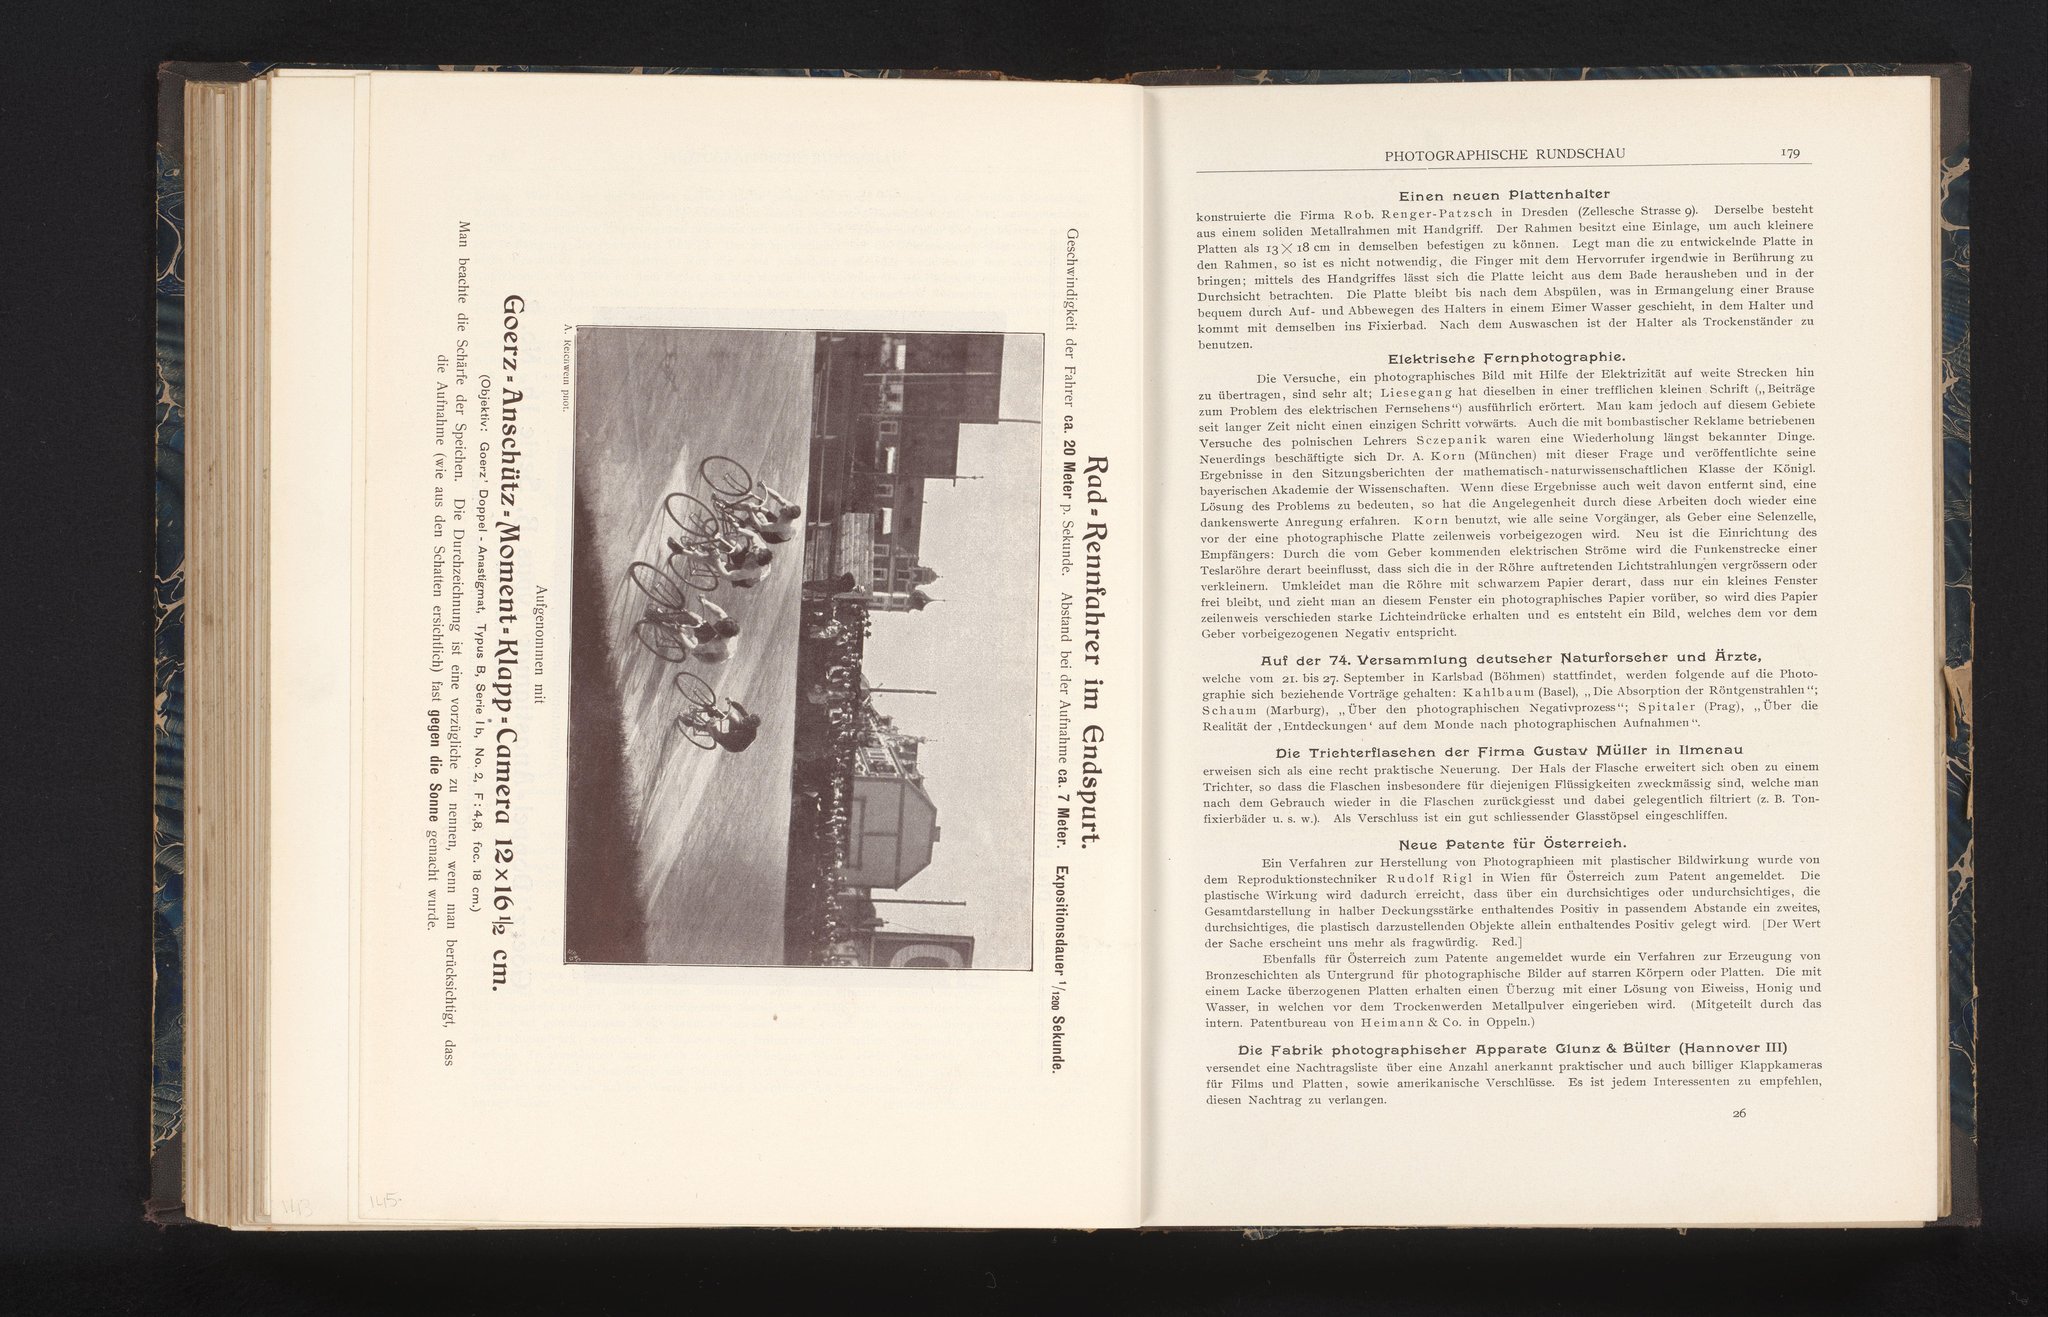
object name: page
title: Gezicht op een aantal wielrenners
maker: a. reichwein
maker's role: fotograaf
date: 1897-1902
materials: paper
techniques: autotype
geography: berlin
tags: bicycle racing, street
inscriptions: inscription: ‘Geschwindigkeit der Fahrer ca. 20 Meter p. Sekunde. Abstand bei der Aufnahmen ca. 7 Meter. Expositionsdauer 1/1200 Sekunde/ (...)’